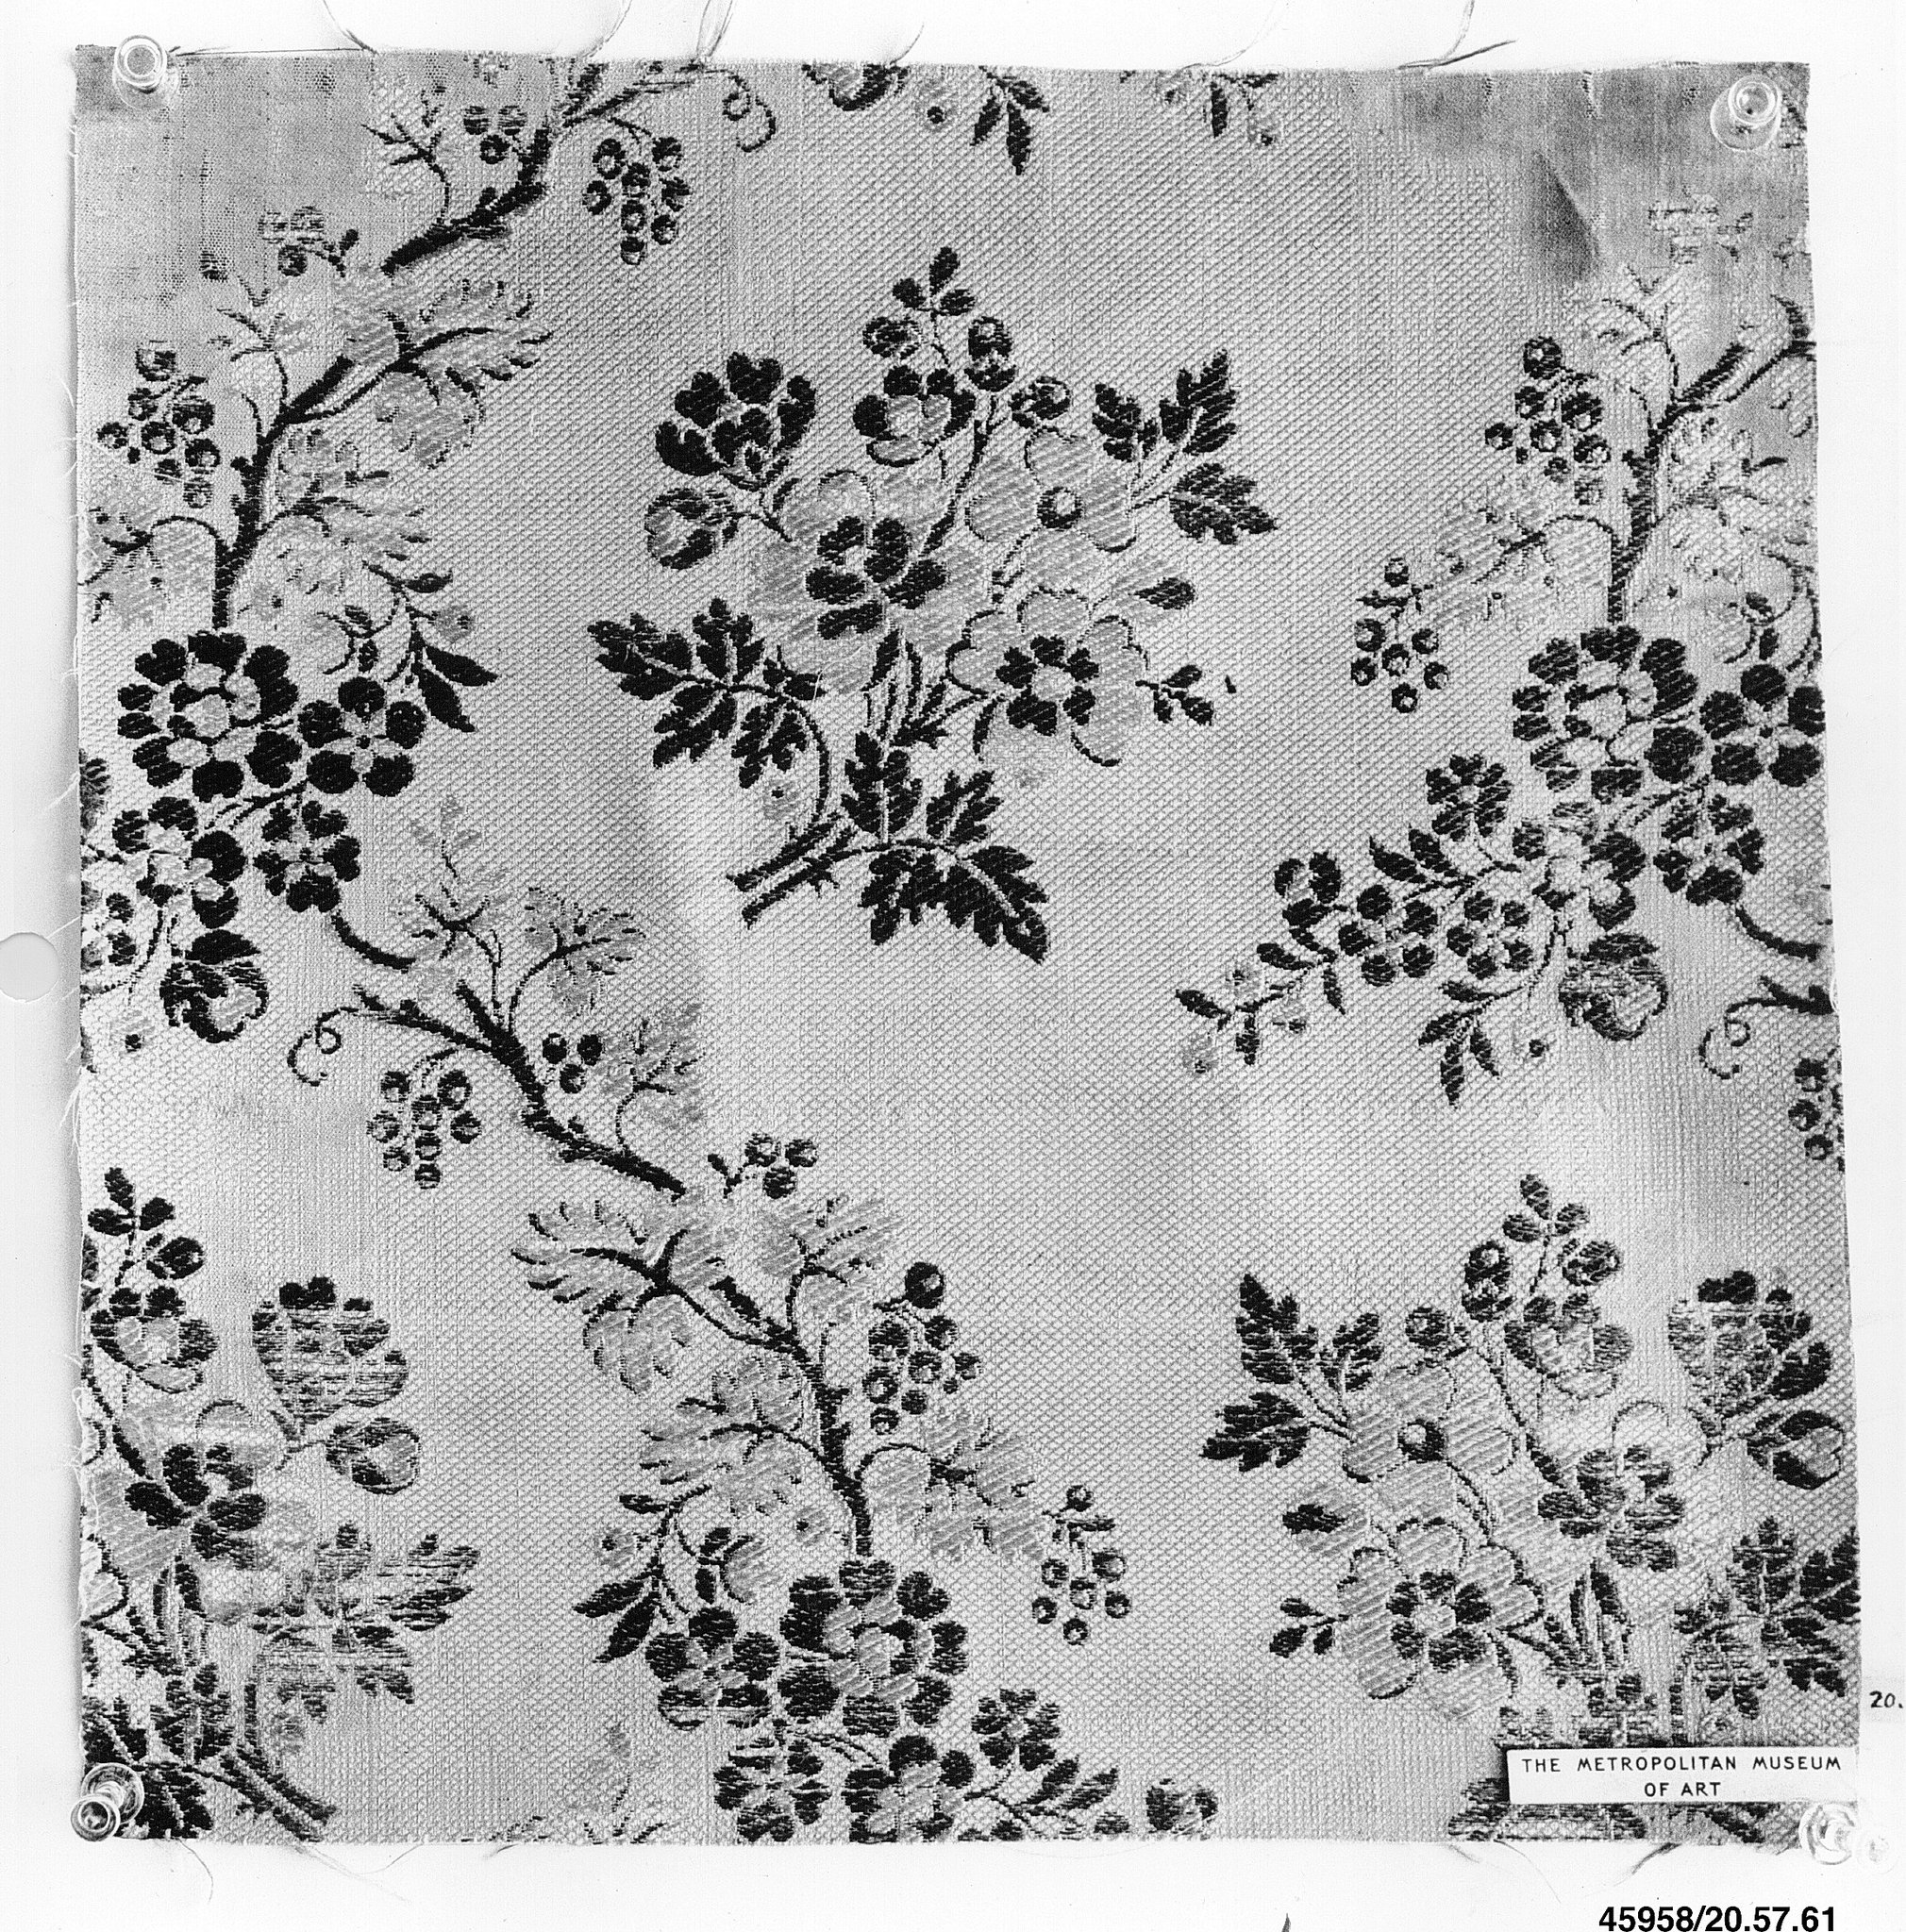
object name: piece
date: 1760-1770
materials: silk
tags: flowers,leaves